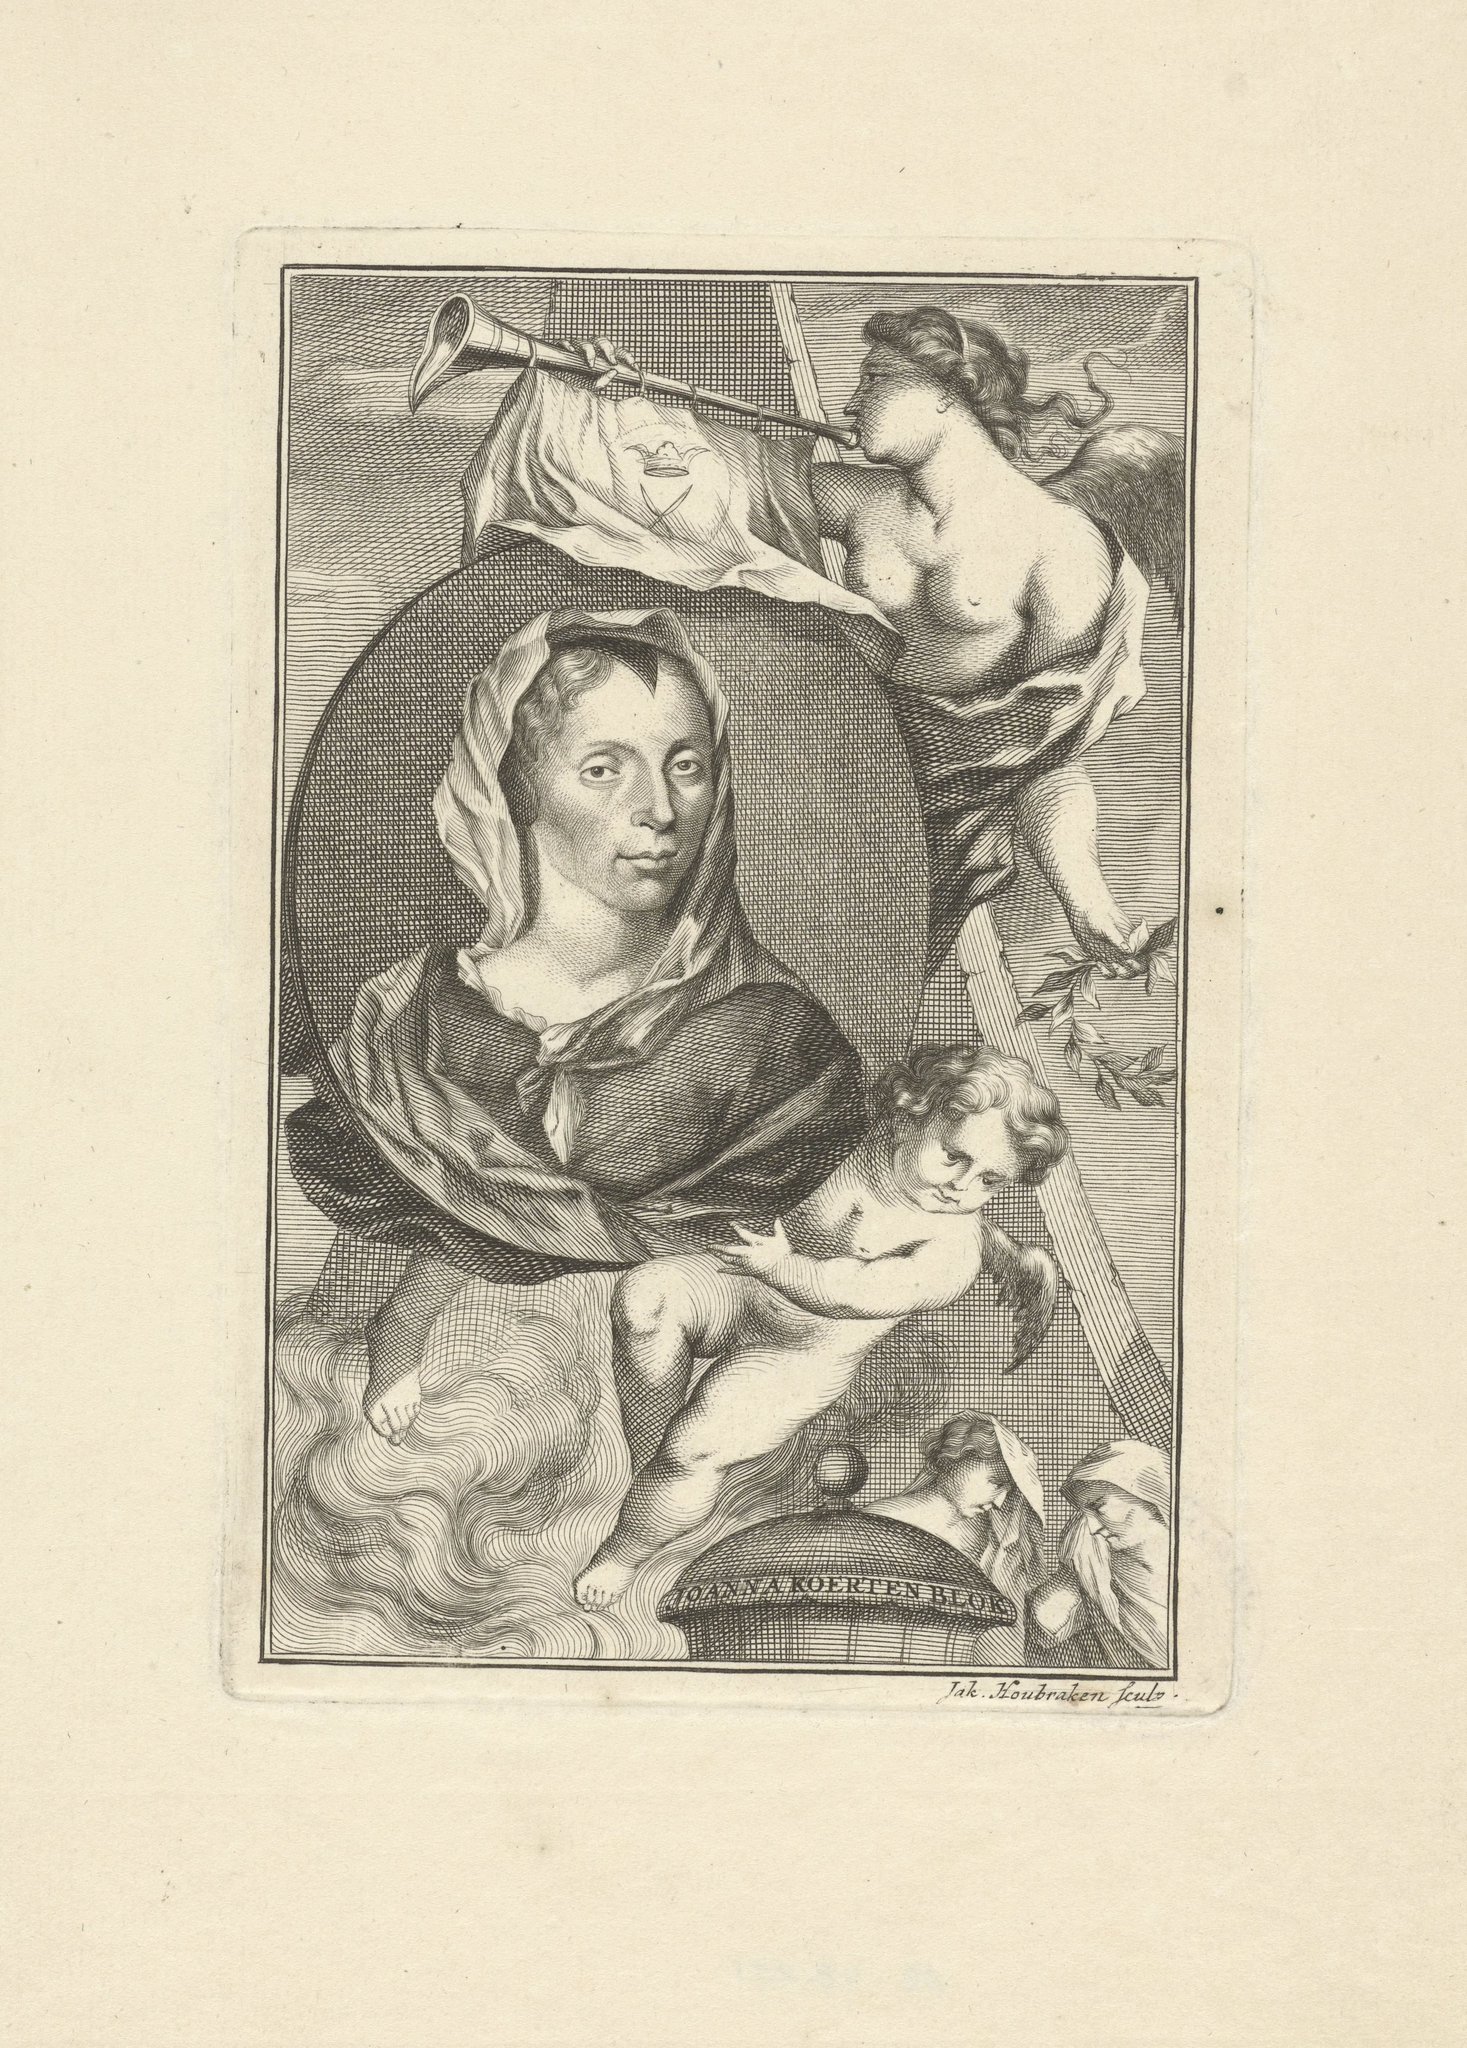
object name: print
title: Portret van Johanna Koerten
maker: jacob houbraken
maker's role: draughtsman, print maker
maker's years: 1698-1780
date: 1716-1718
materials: paper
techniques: engraving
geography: amsterdam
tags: amsterdam, draughtsman, johanna koerten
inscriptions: collector's mark: Lugt 240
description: Latere staat van de prent ook gebruikt in: Arnold Houbraken. De groote Schouburgh der Nederlantsche konstschilders en schilderessen : waar van 'er vele met hunne beeltenissen ten tooneel verschynen, ... zynde een vervolg op het Schilderboek van K. van Mander. 3 dln. Eerste druk. Amsterdam: 1718-1721.